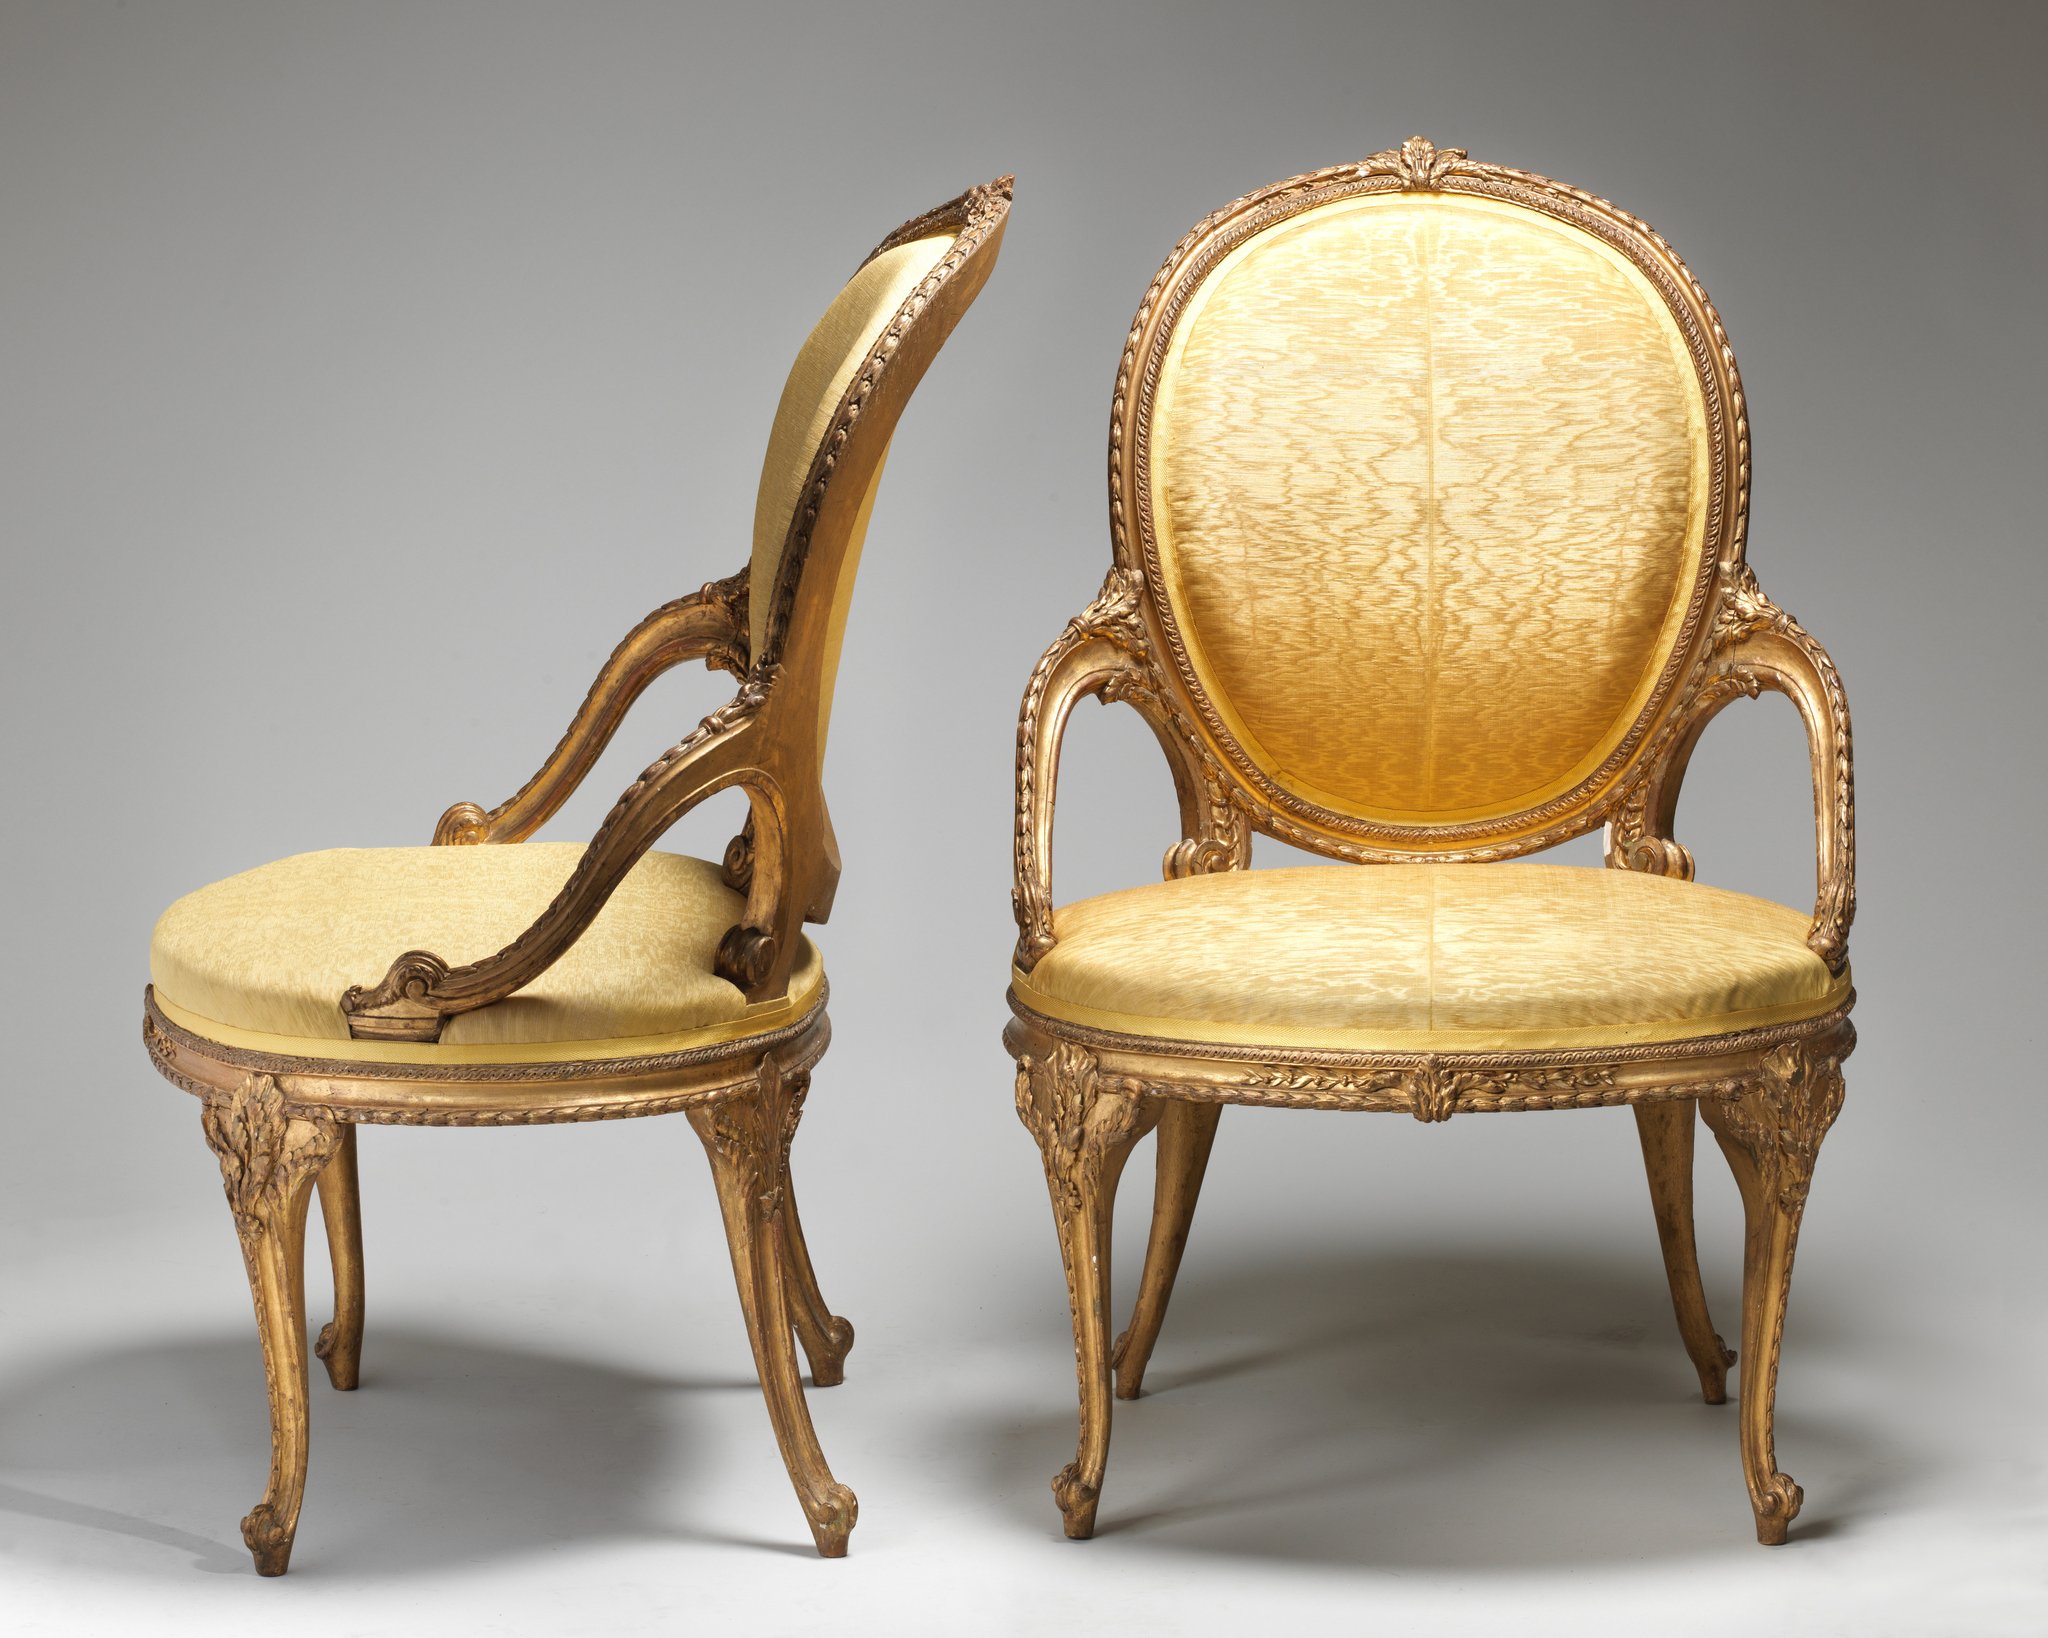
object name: armchair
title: Pair of armchairs (part of a set)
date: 1770-1780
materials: wood, gilt, silk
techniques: carving